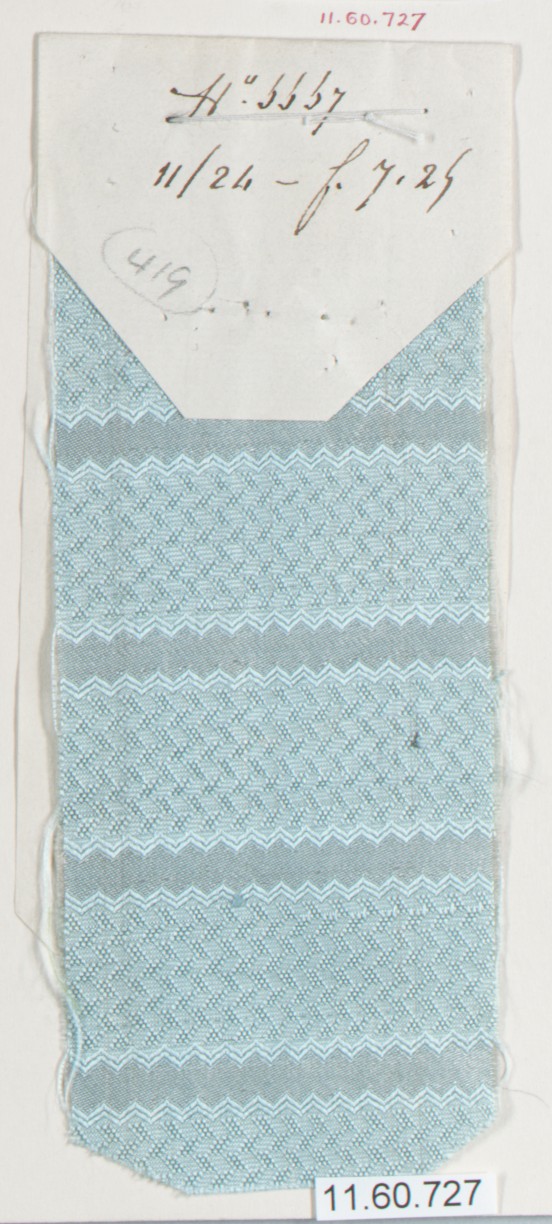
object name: sample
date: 1801-1850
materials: silk